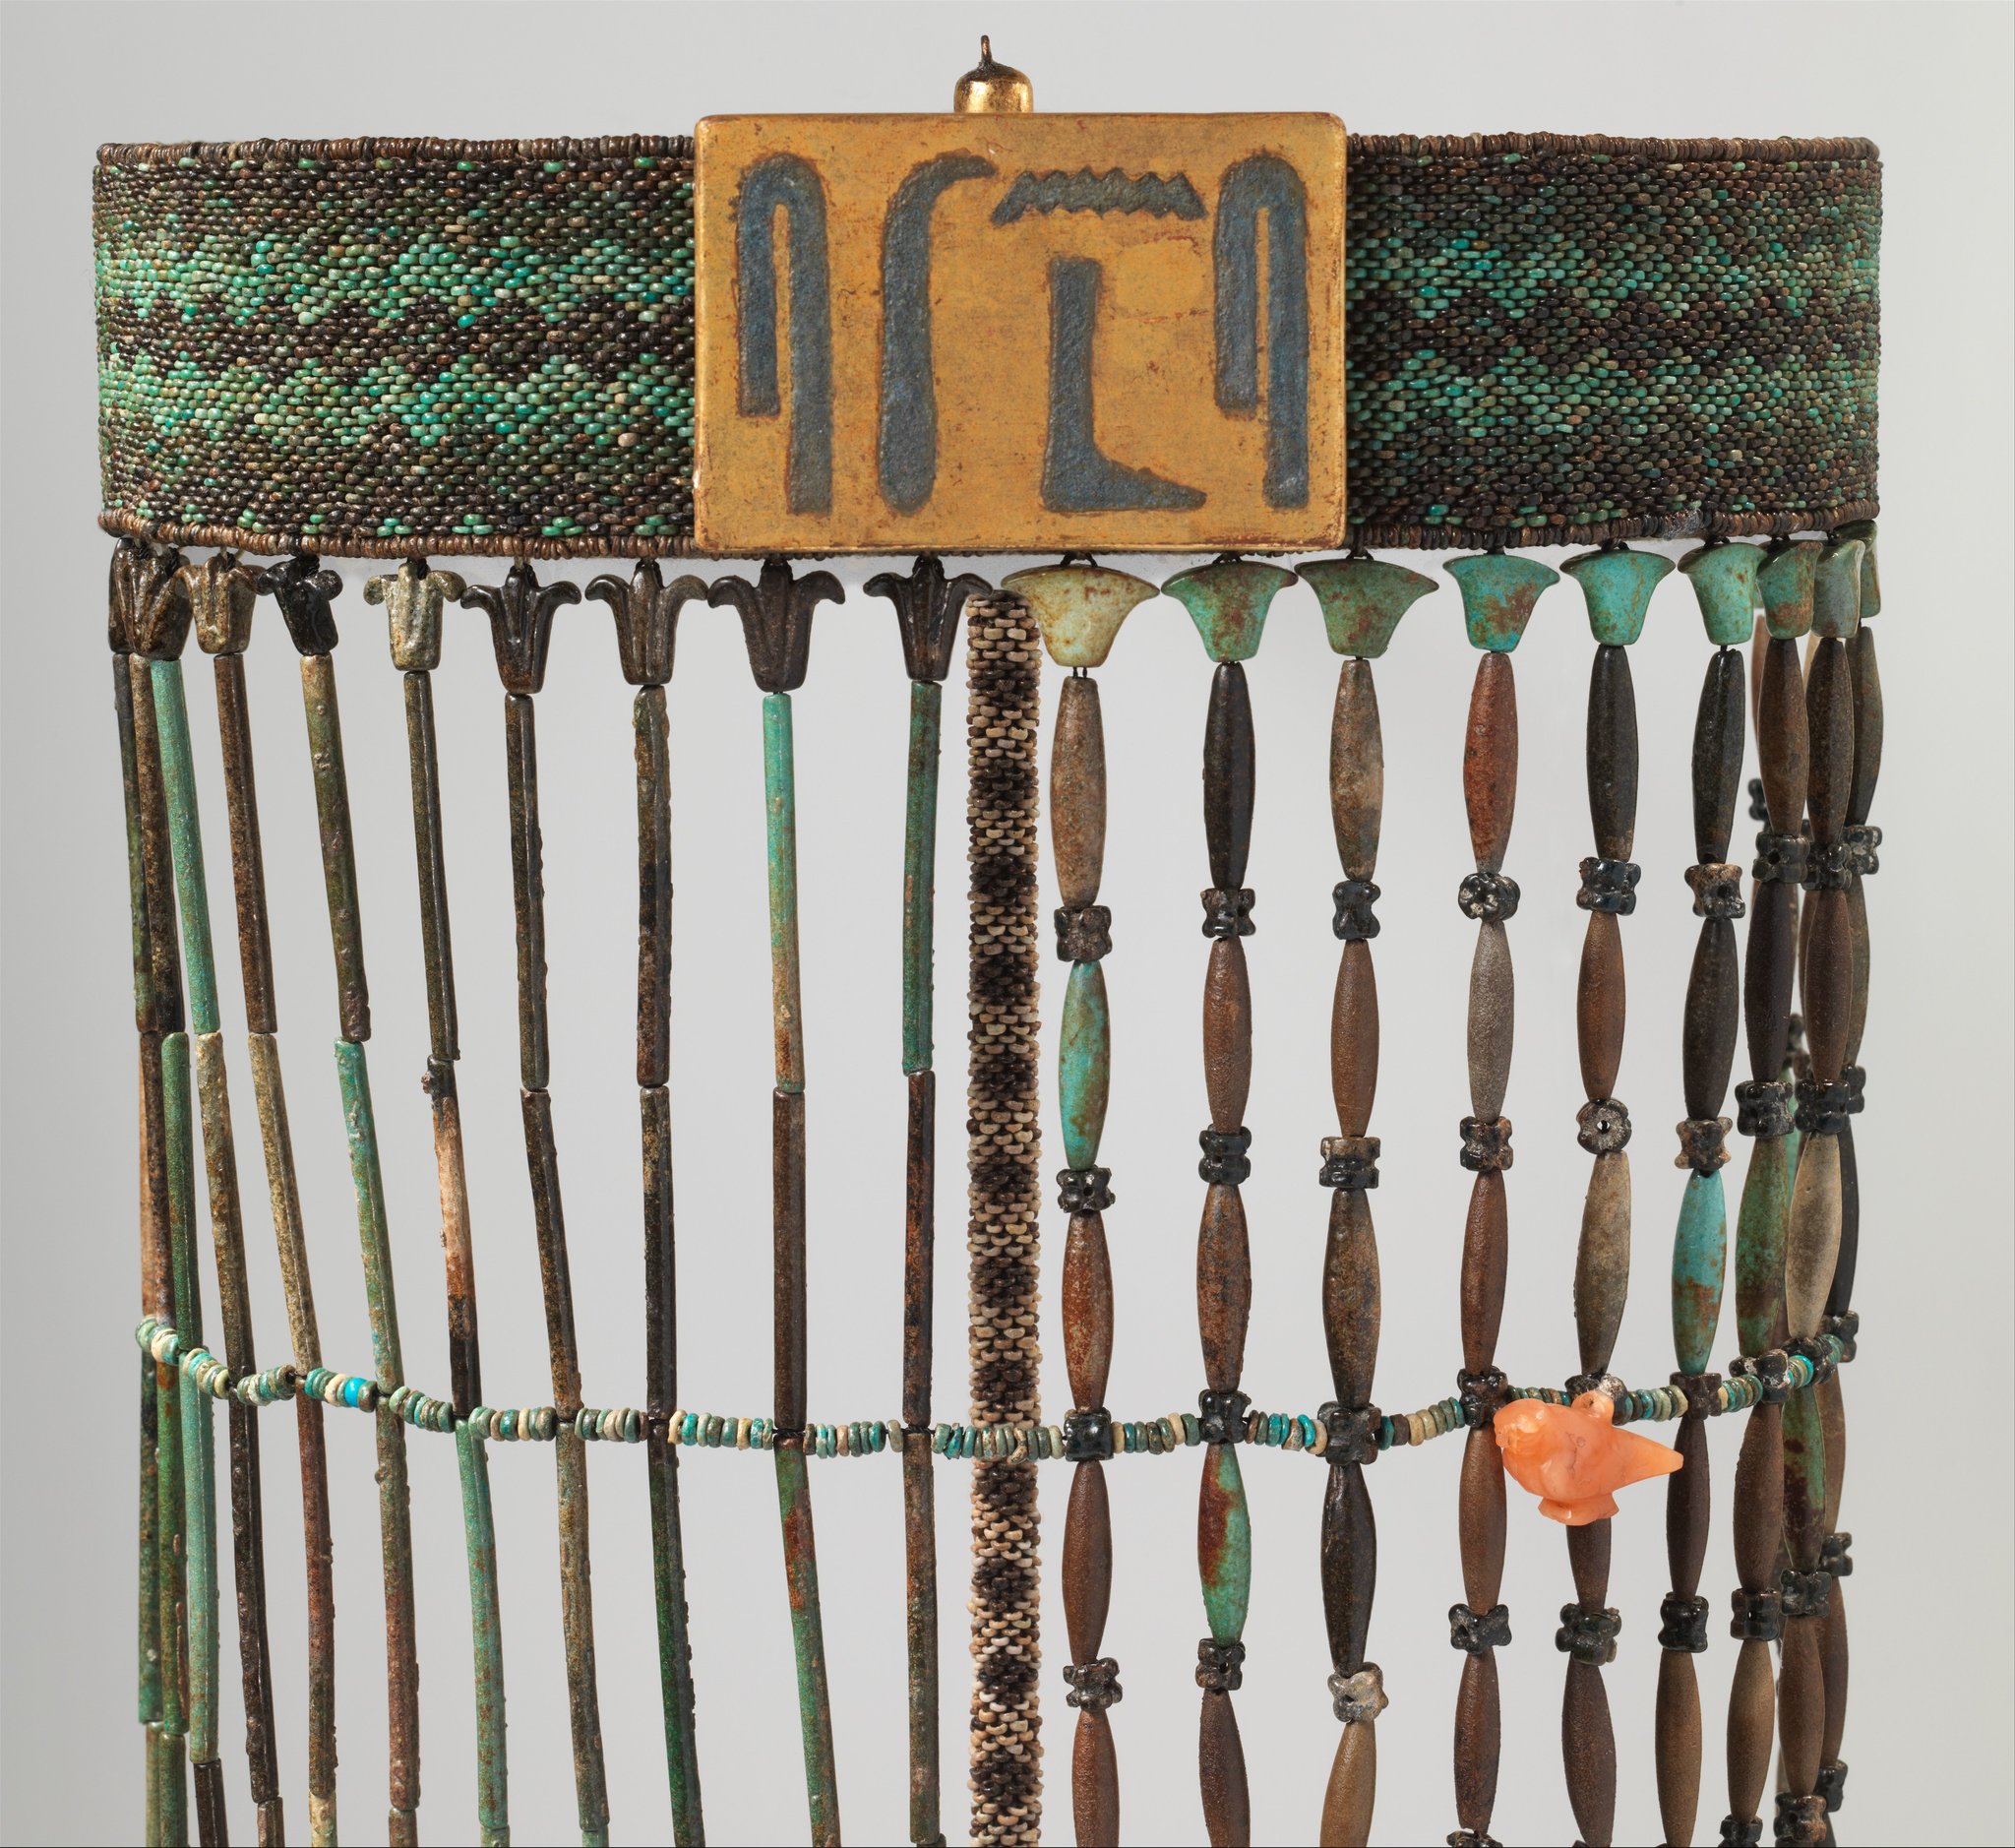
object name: amulet, falcon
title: Falcon amulet of Senebtisi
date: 1850-1775 BCE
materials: gemstone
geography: egypt